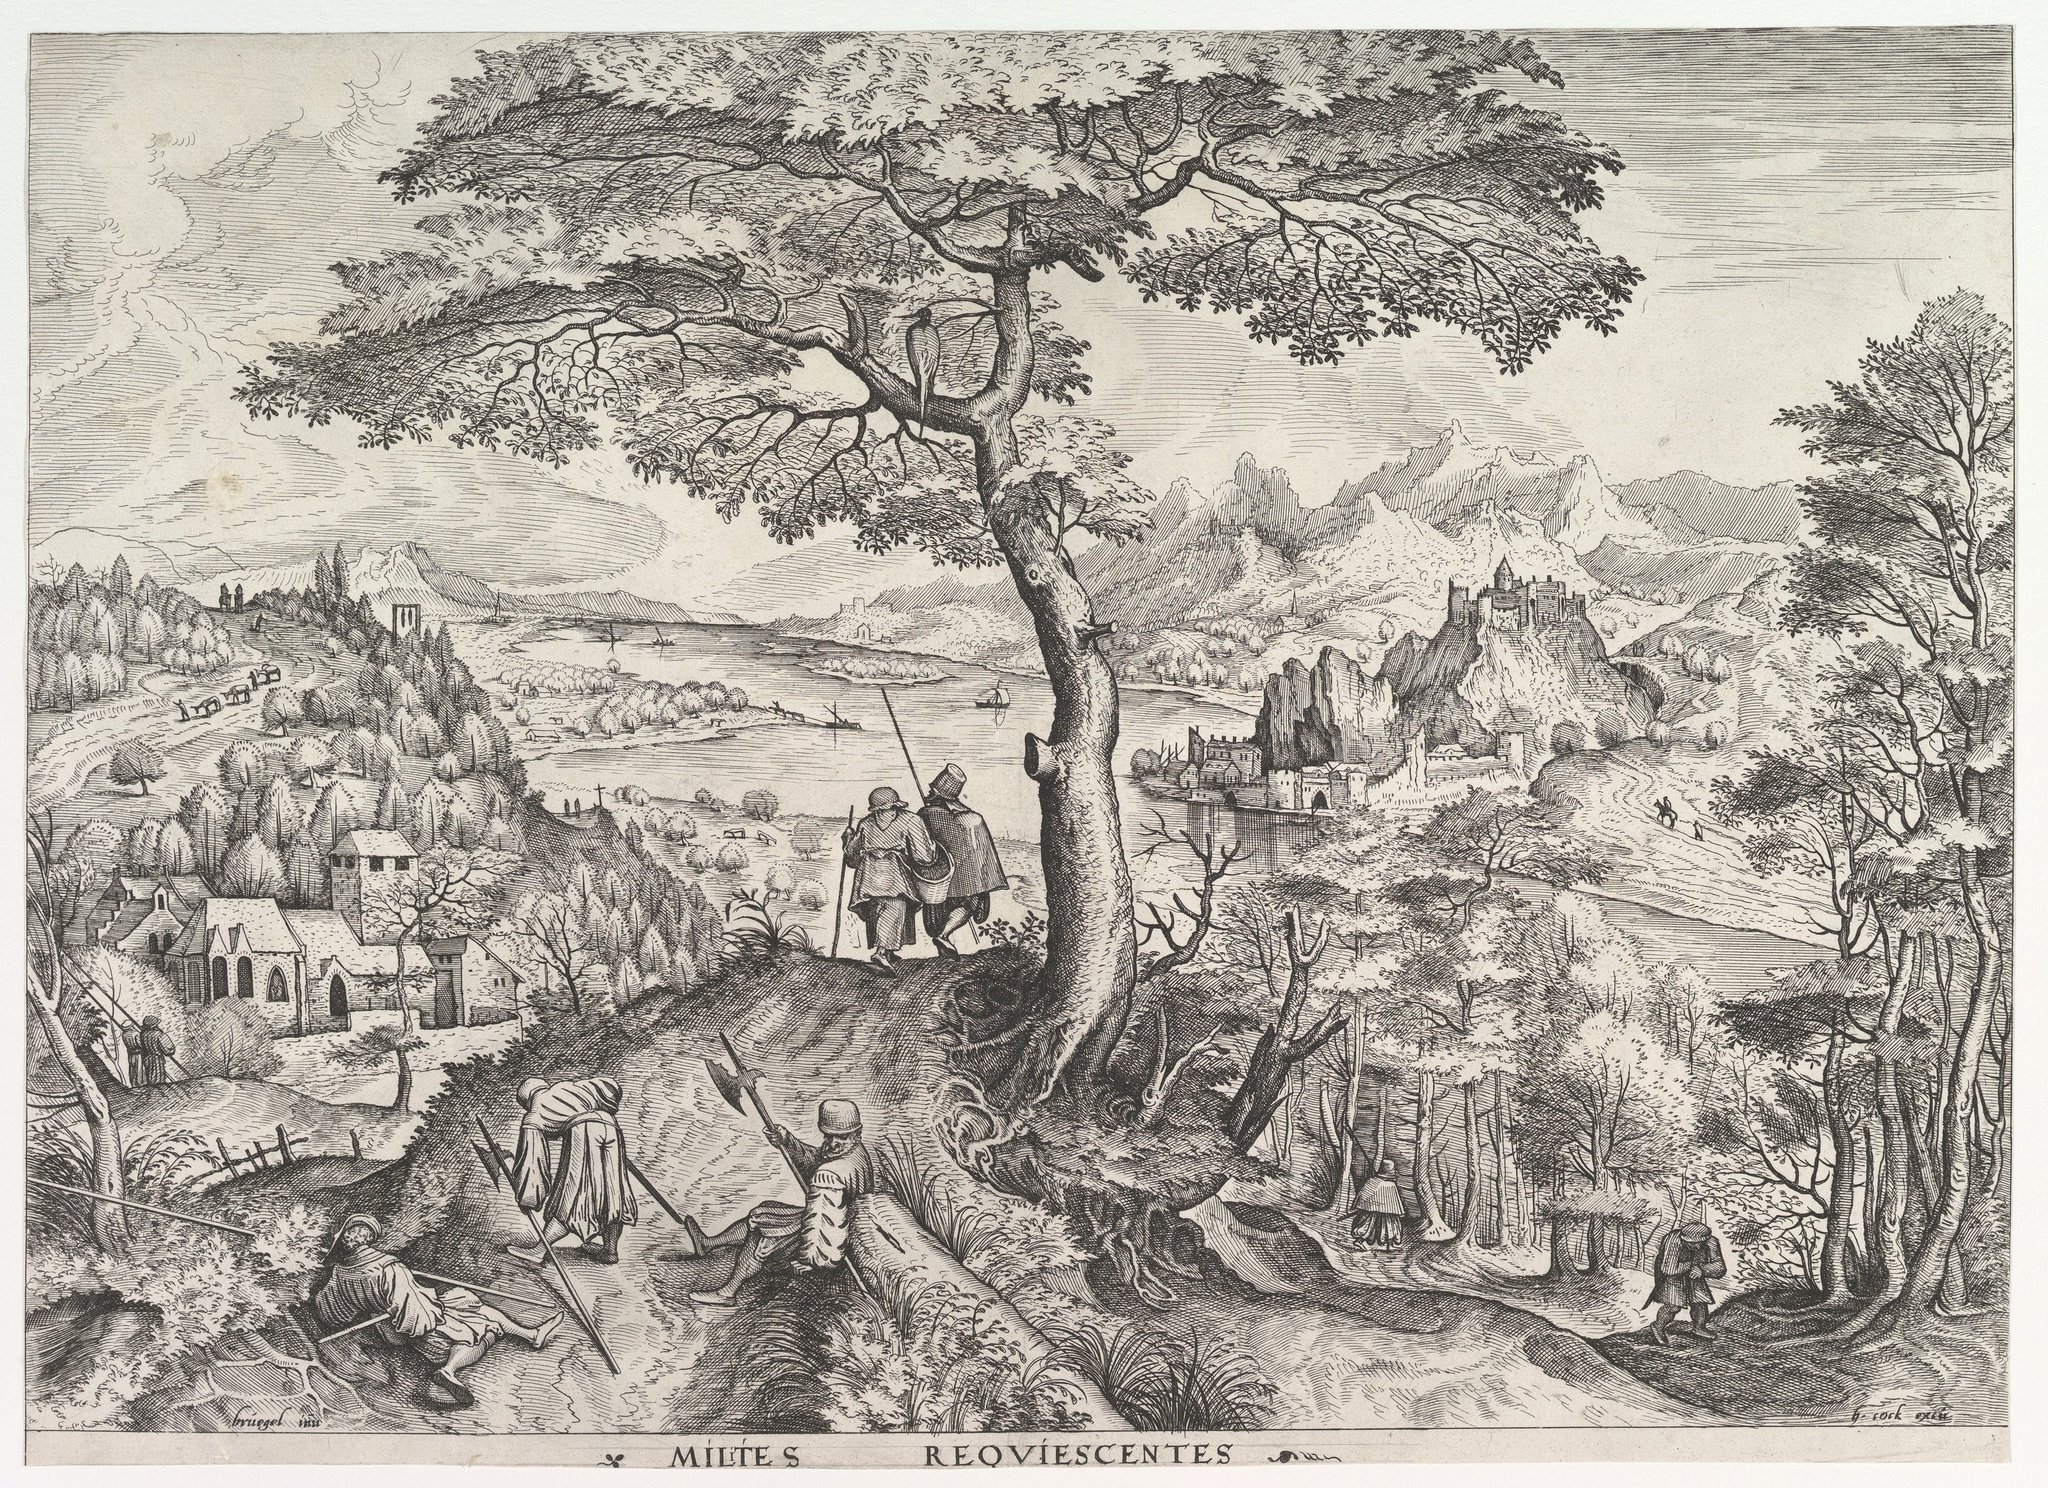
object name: print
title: Soldiers at Rest (Milites requiescentes), from "The Large Landscapes"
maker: johannes van doetecum i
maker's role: artist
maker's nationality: netherlandish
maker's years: 1528-1605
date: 1555-1556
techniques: engraving, etching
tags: buildings,soldiers,men,landscapes,trees